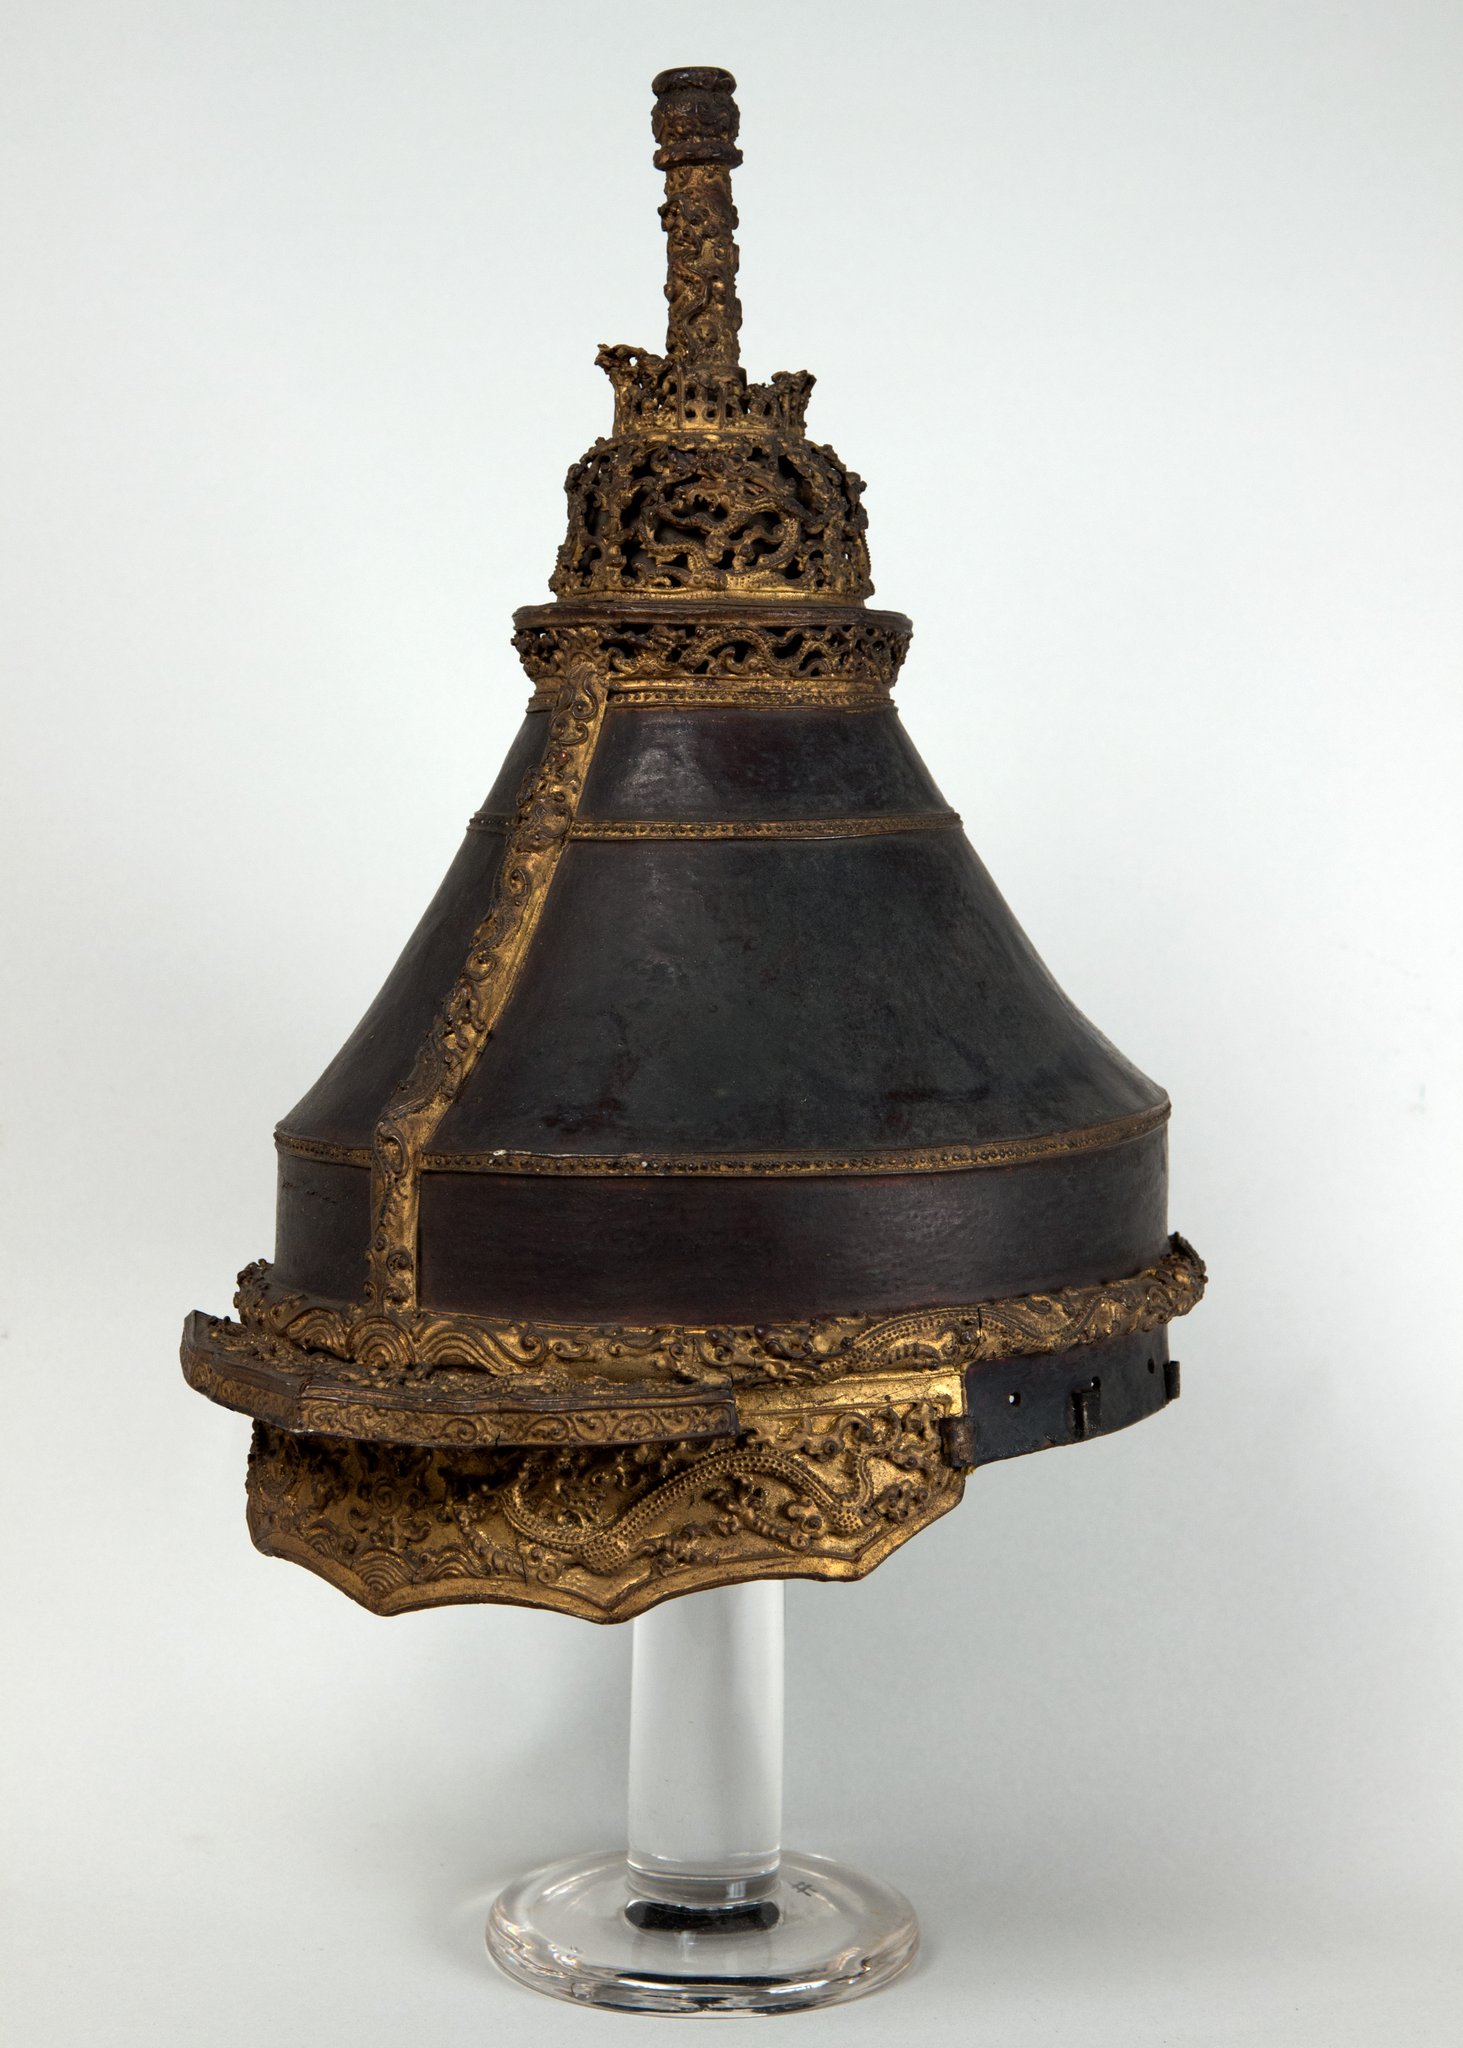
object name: papier maché copy of a chinese helmet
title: Papier Maché Copy of A Chinese Helmet Probably theatrical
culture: chinese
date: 1701-1900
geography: china